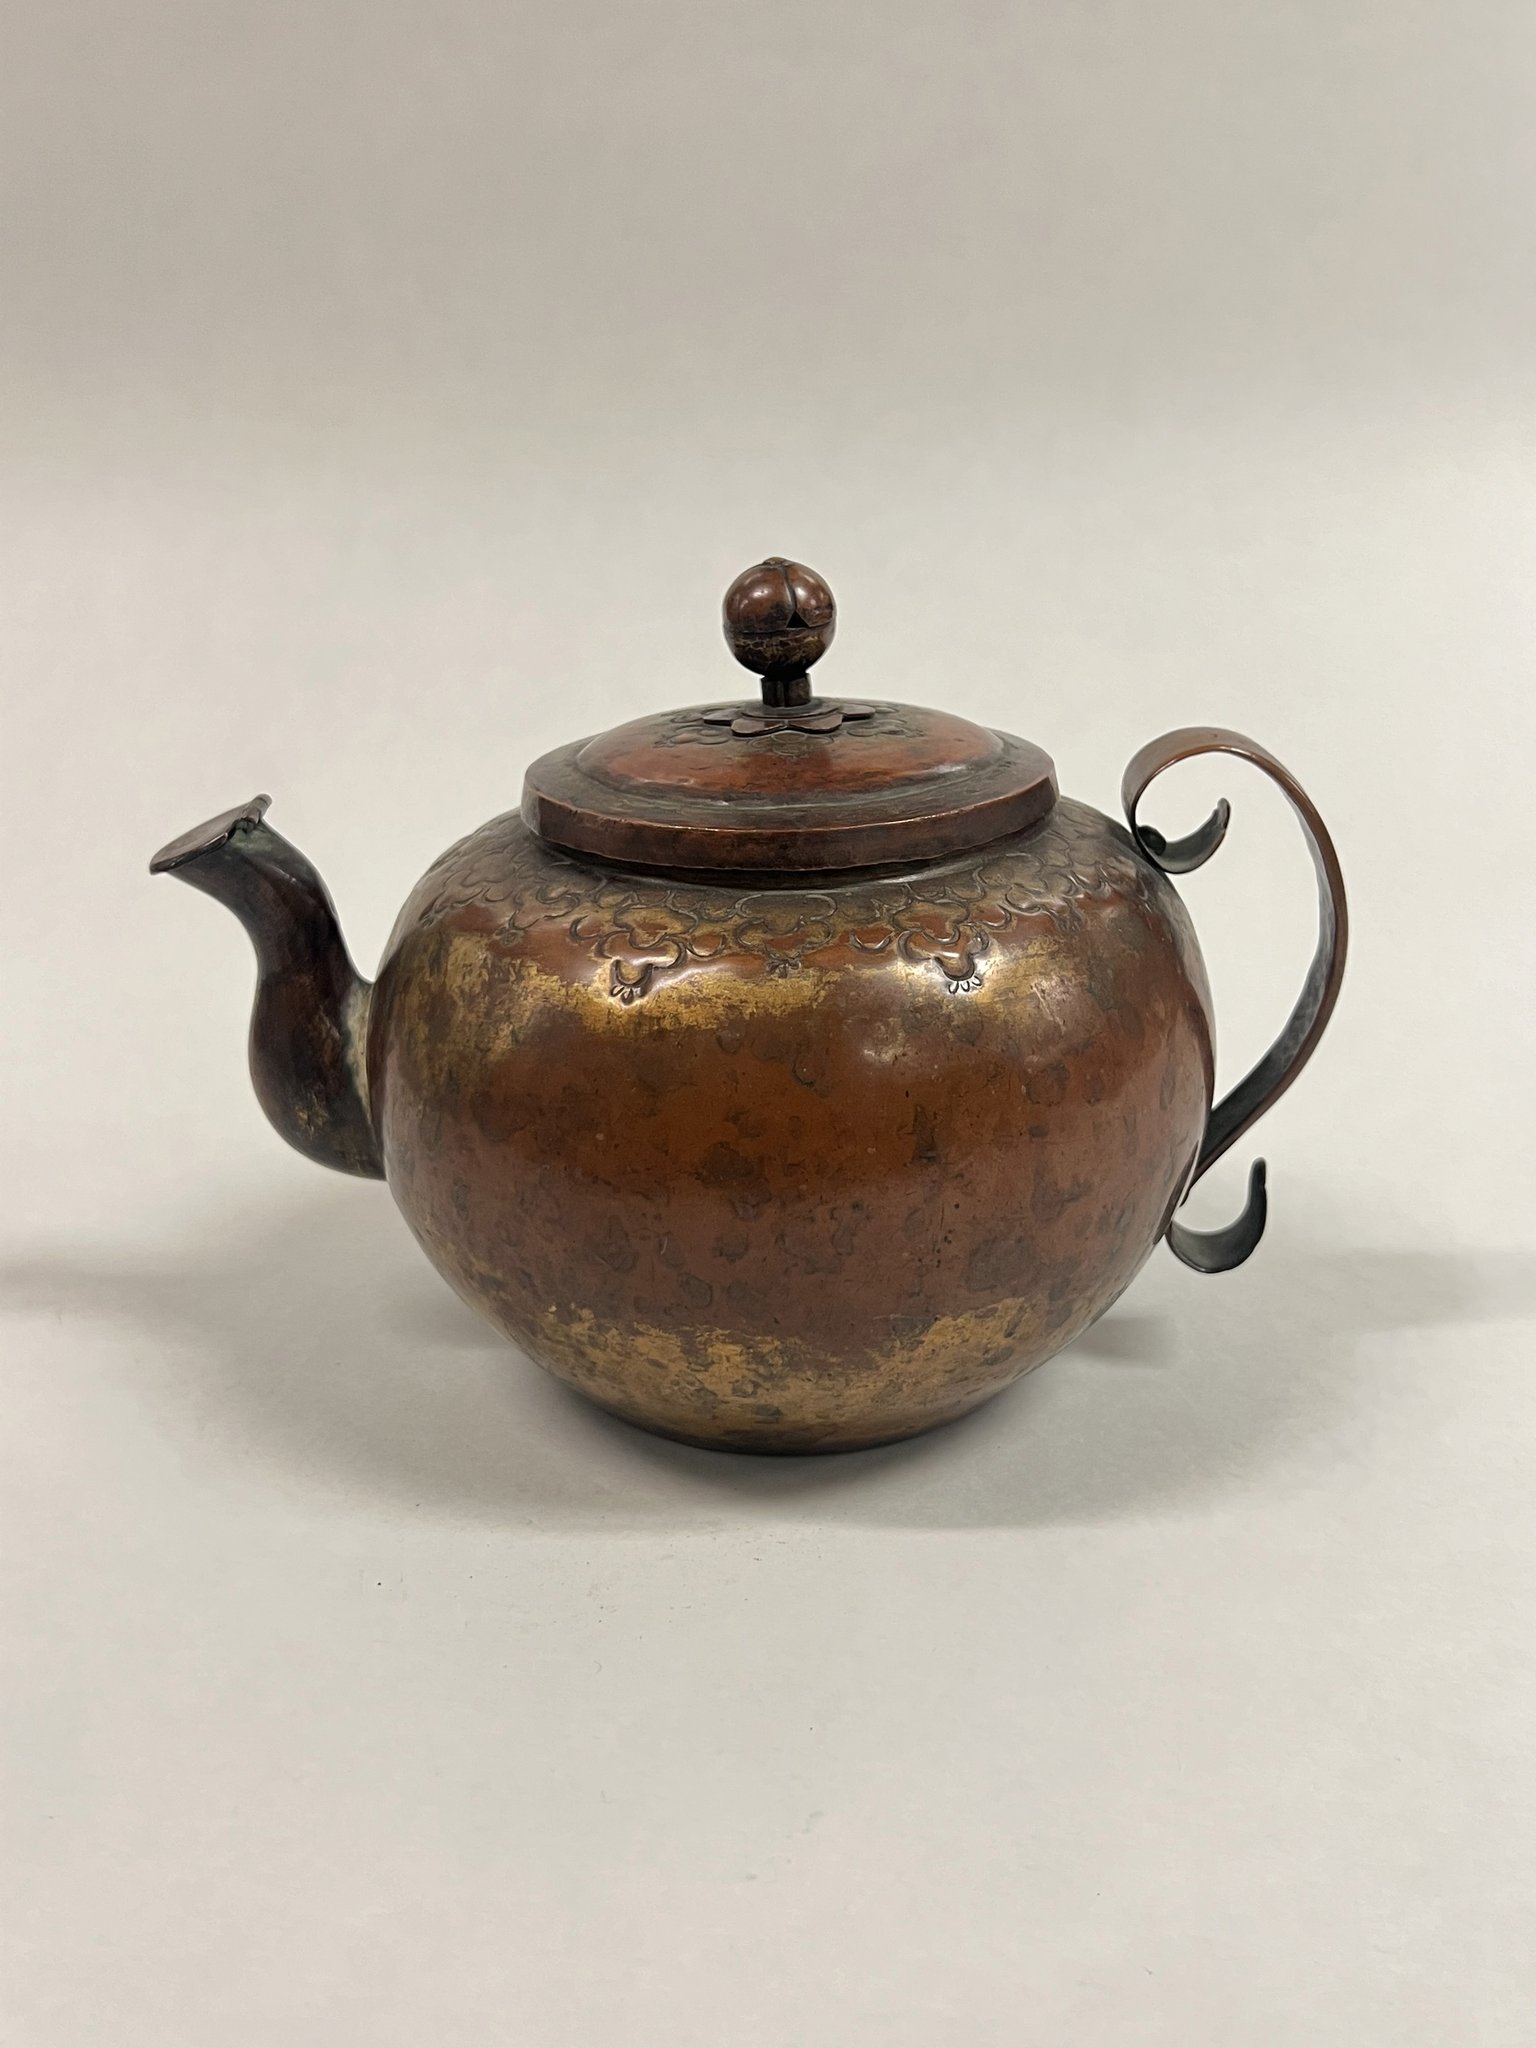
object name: pot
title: Pot for Wine or Tea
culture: japanese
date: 1801-1900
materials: bronze